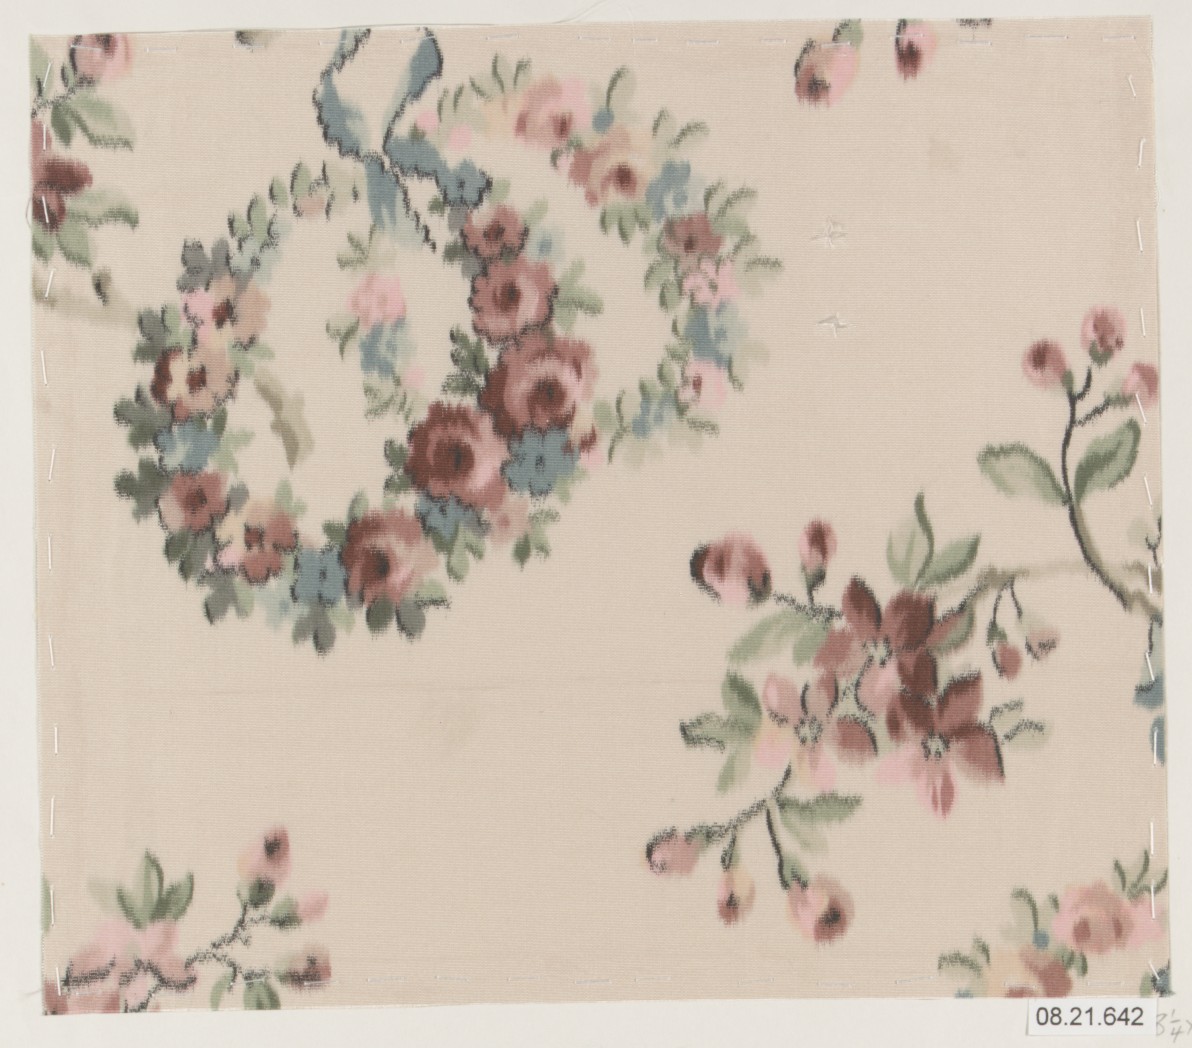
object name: textile sample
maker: Anonymous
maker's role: designer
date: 1900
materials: silk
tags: flowers